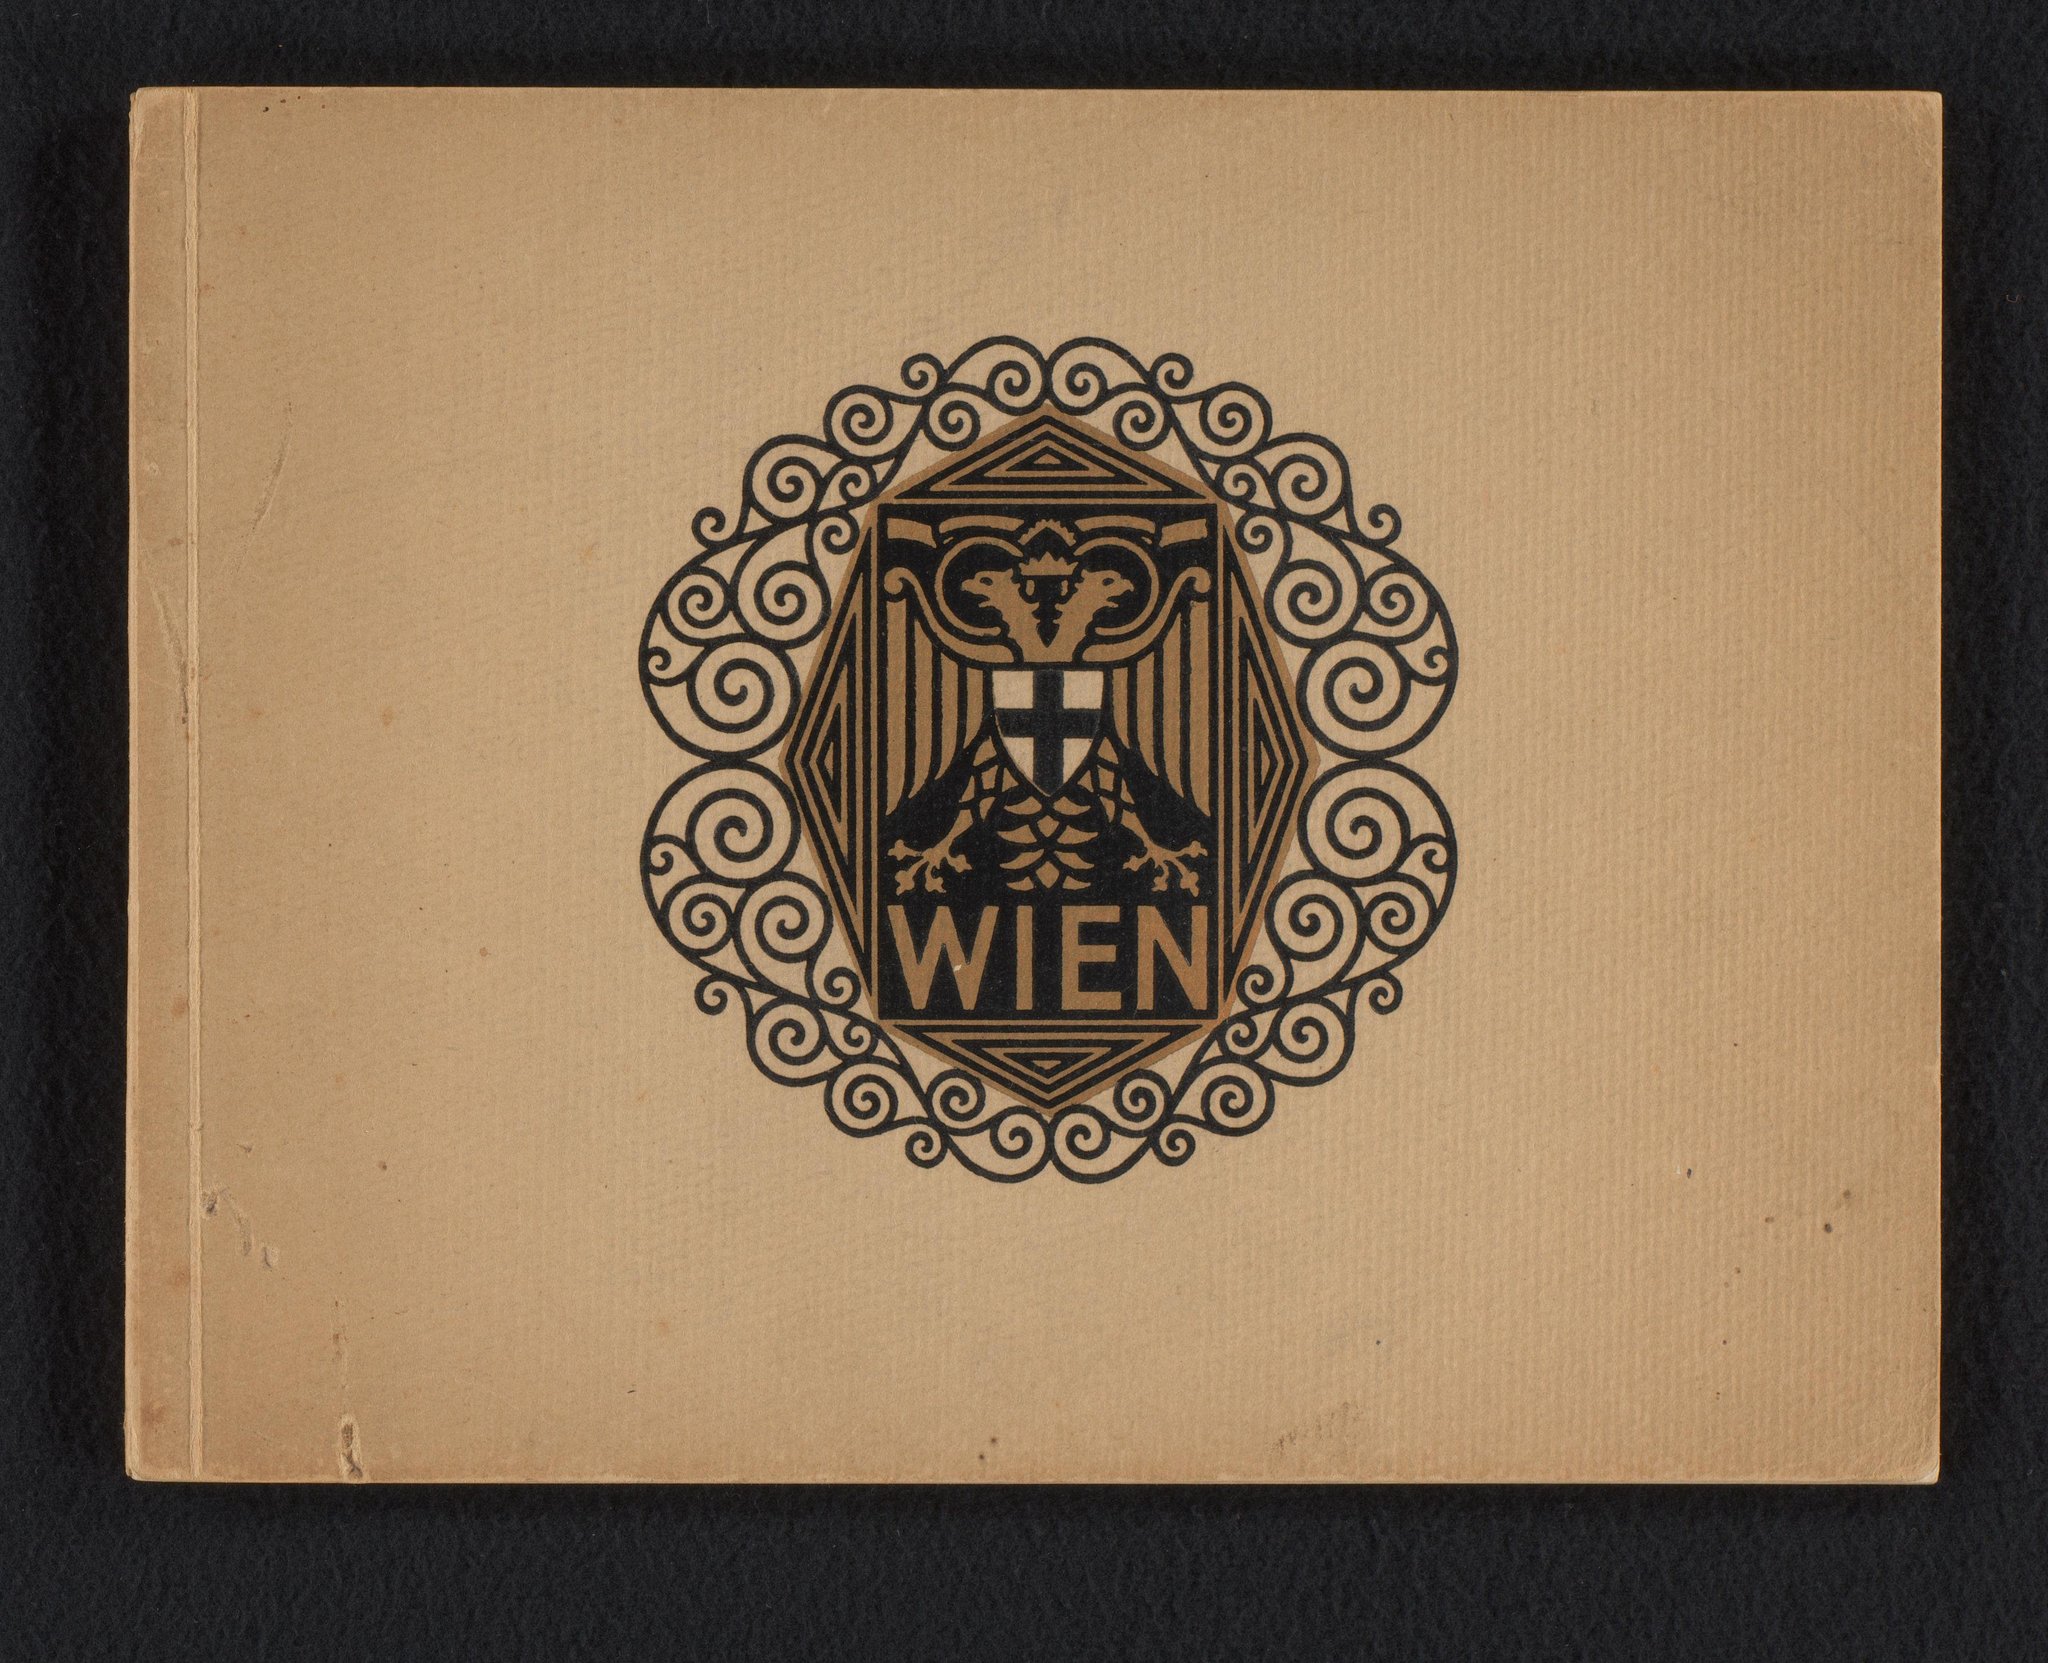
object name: photobook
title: Lechners Album von Wien. Ein Spaziergang durch die Stadt und ihre Umgebung in 152 Bildern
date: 1923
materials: cardboard, ink, paper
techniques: letterpress printing, pen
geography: vienna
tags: city-view in general; 'veduta', street, vienna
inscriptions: inscription: ‘Herrn Hoofdinspektor Broekhoff zum/ freundlichen Erinnerung an den Internationa-/ len Polizei Kongress in Wien 3-7. September 1923/ Schober’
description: Fotoboek met 152 fotomechanische afdrukken van straatgezichten in Wenen.